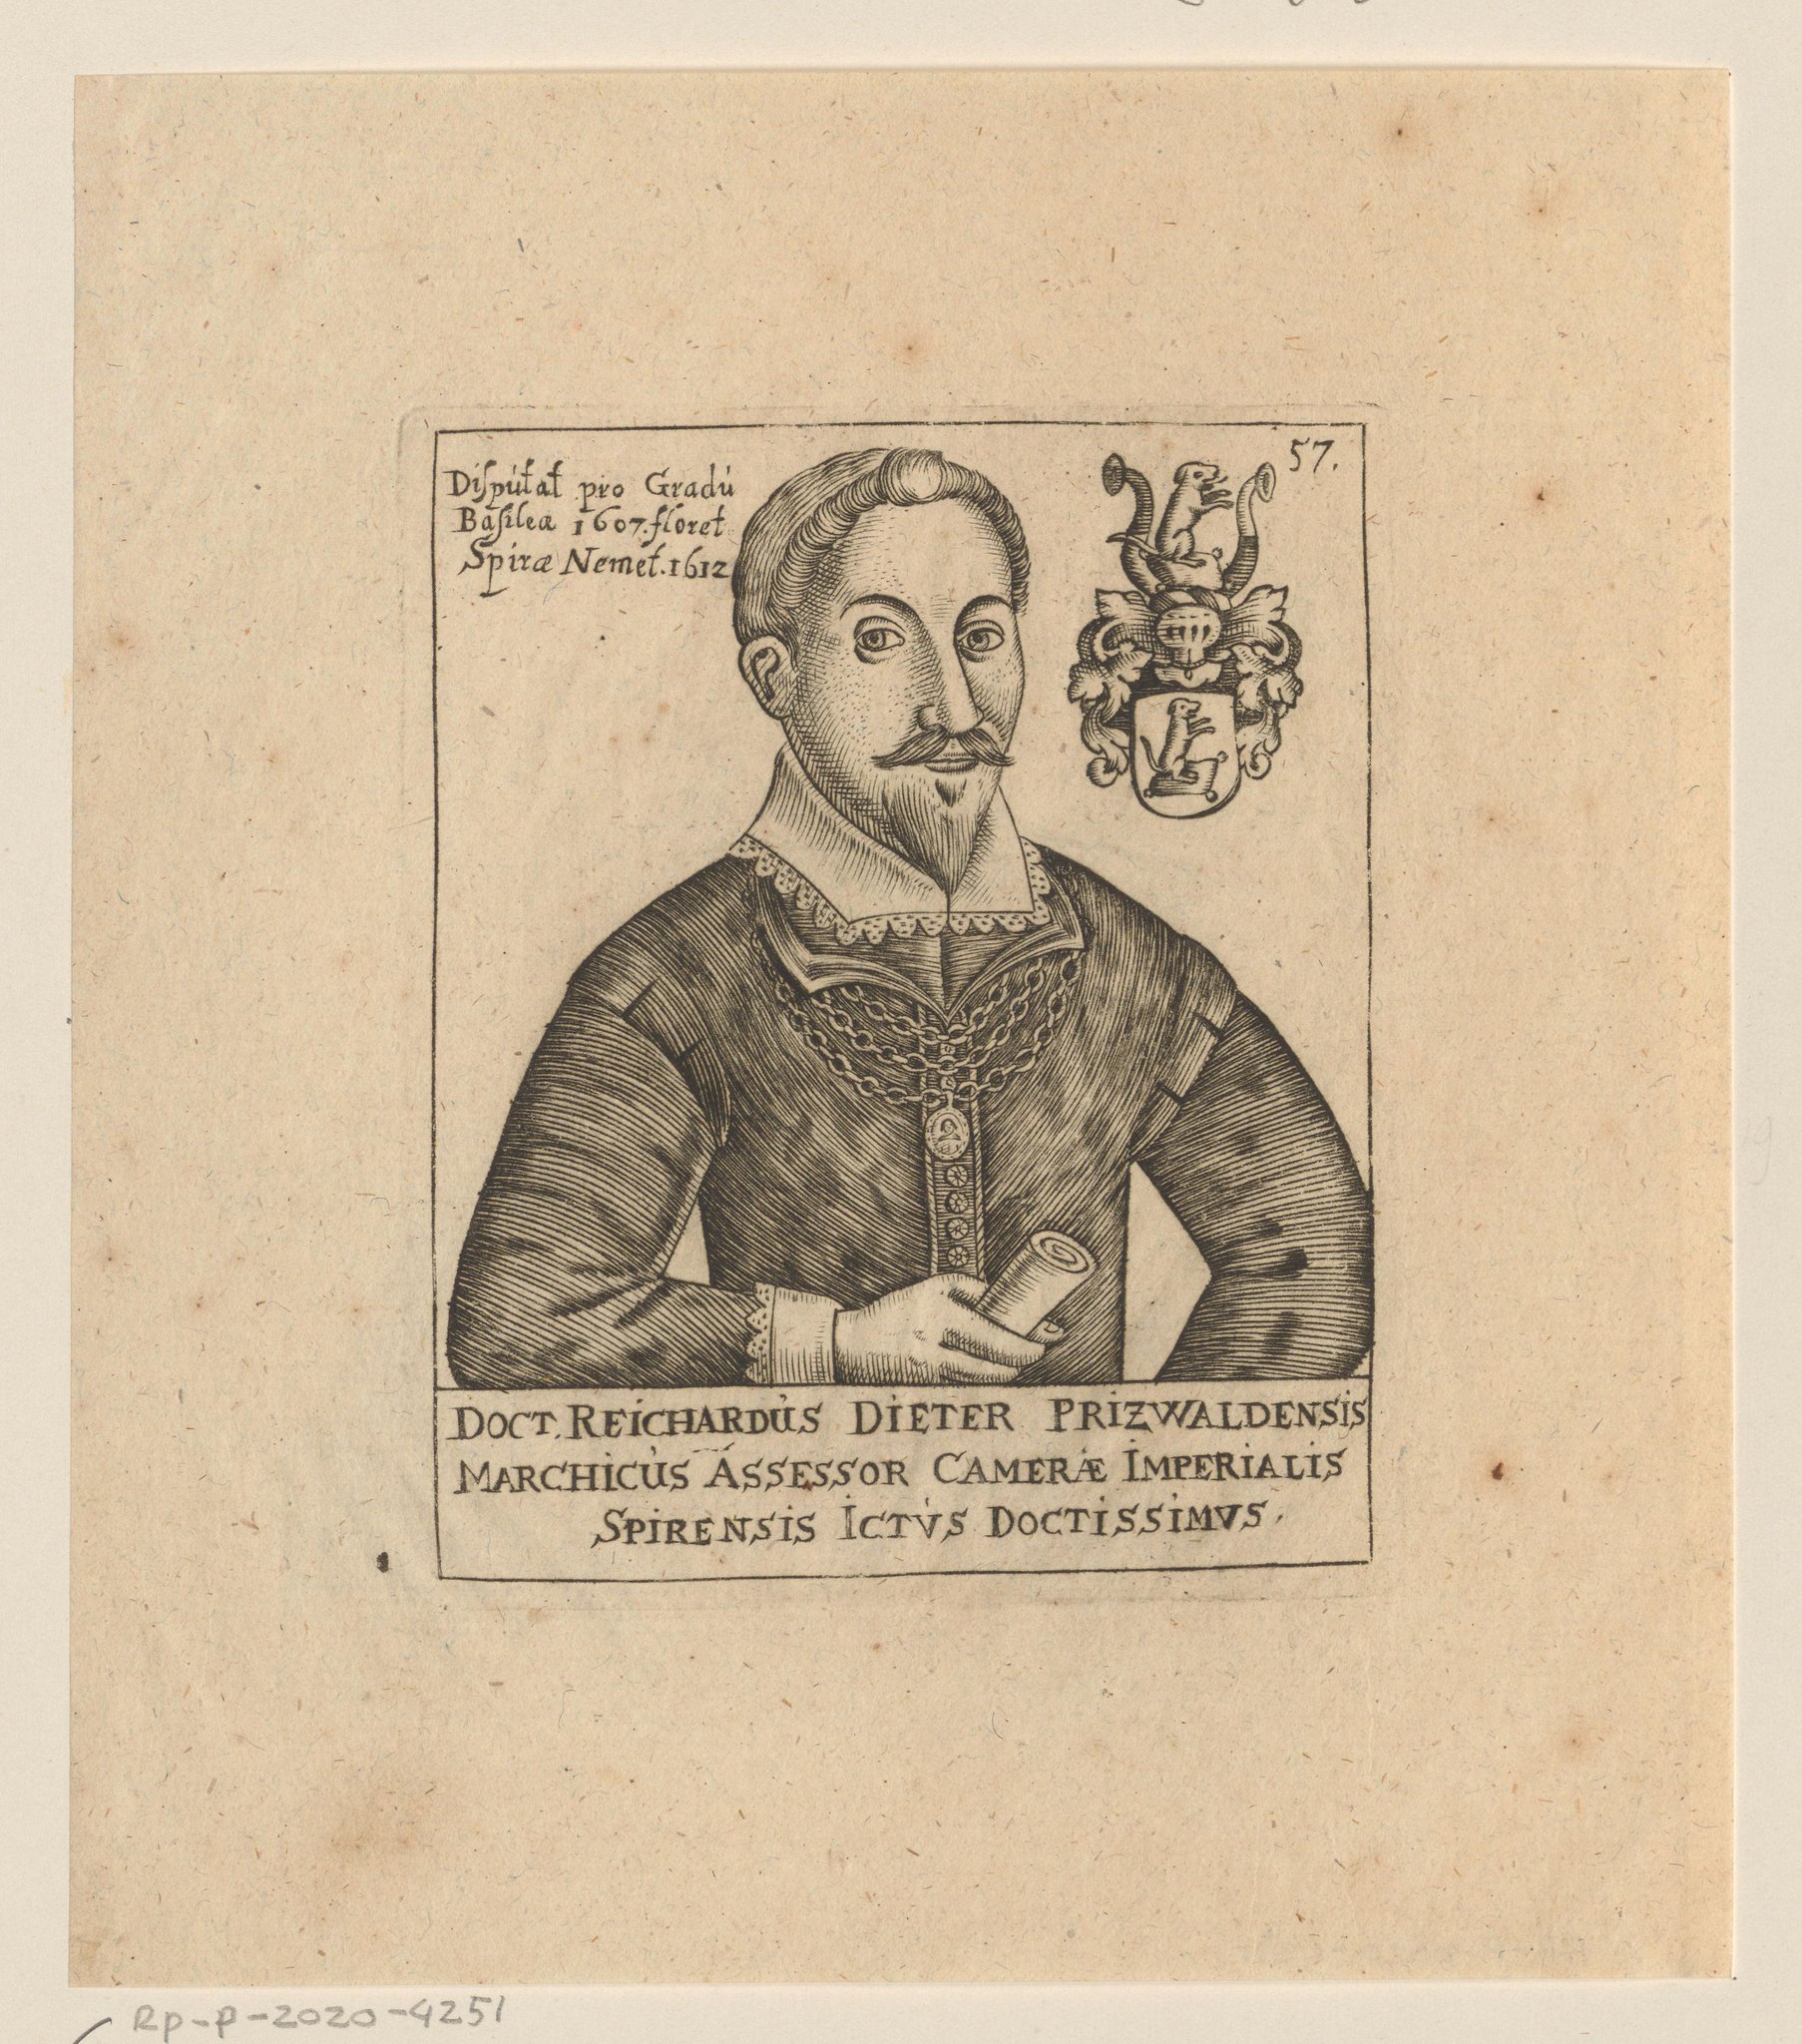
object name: print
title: Portret van Reichard Dieter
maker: Anonymous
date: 1751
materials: paper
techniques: engraving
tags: historical persons, law and jurisprudence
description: Prent waarschijnlijk uit: Küster, Georg Gottfried, en Martin Friedrich Seidel. Martin Friedrich Seidels Bilder-Sammlung (...). Berlijn: Verlag des Buchladens bey der Real-Schule, 1751.